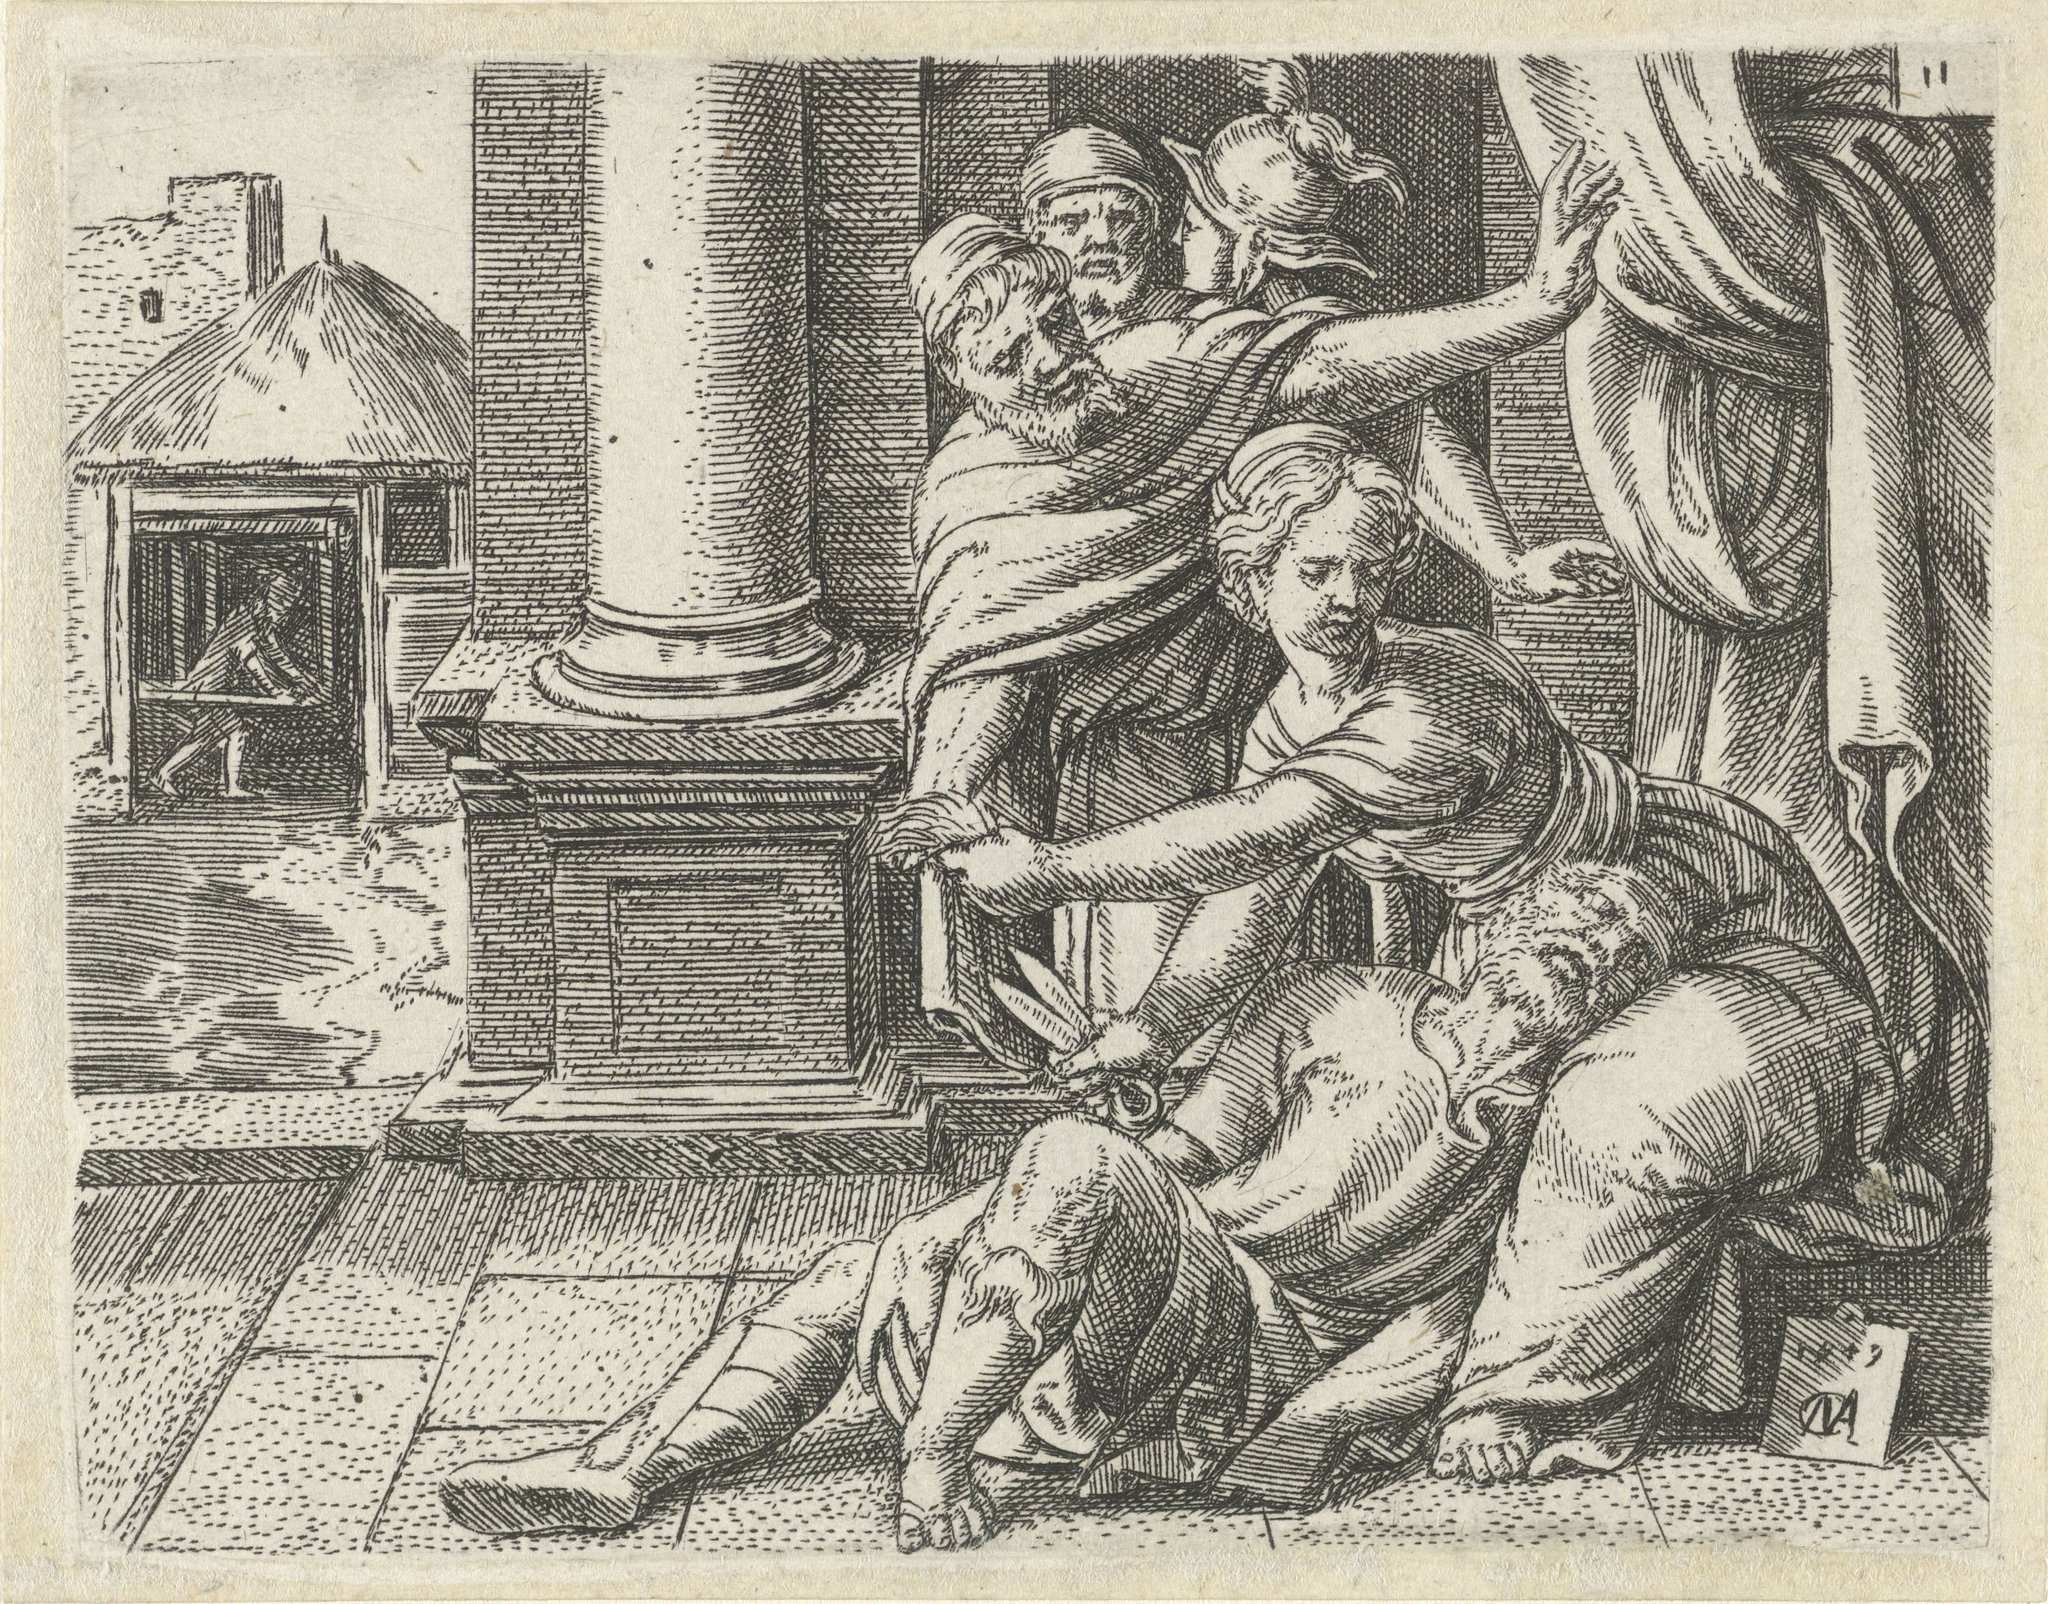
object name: print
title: Simson en Delila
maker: cornelis massijs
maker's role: painter, print maker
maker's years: 1510-1557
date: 1549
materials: paper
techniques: engraving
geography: antwerp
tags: samson grinding in prison (in a treadmill), samson's hairlocks are cut off by delilah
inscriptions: collector's mark: Lugt 2228, collector's mark: Lugt 2542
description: Simson ligt met zijn hoofd op Delila's schoot te slapen, terwijl zij zijn haren afknipt. Drie Filistijnen staan klaar om Simson gevangen te nemen. Links op de achtergrond maalt de gevangen en blind gemaakte Simson meel.